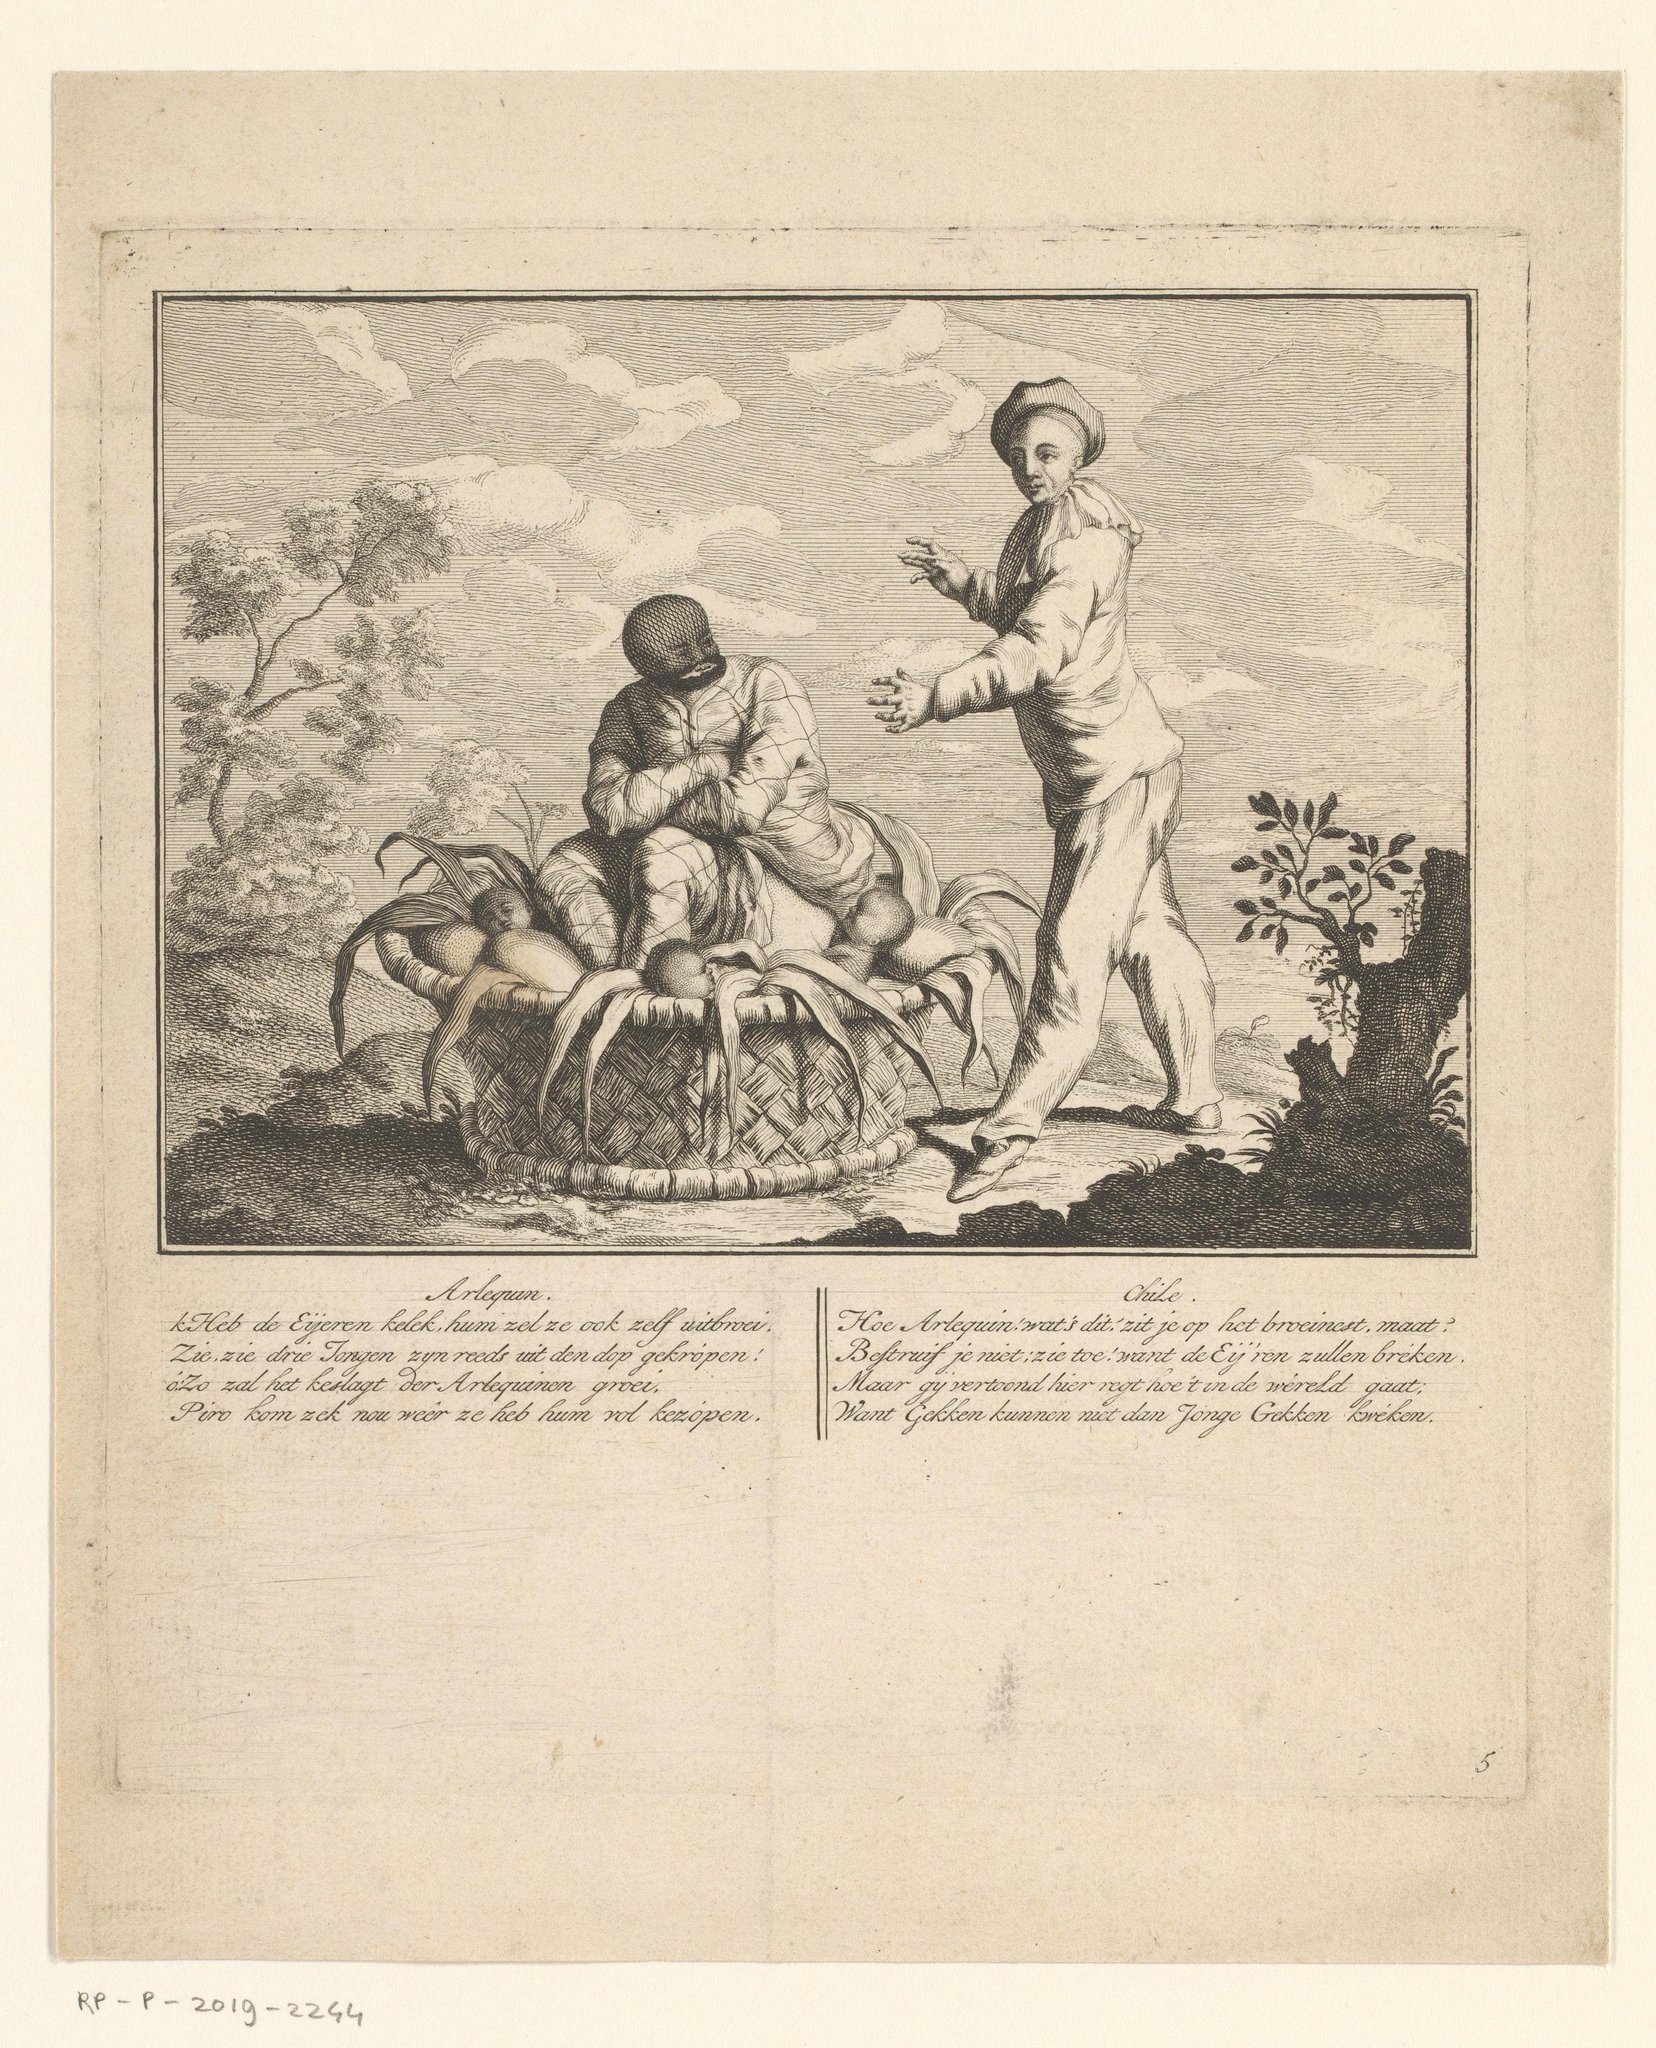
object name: print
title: Arlequin als opvoeder van de kleine Arlequin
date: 1720-1728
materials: paper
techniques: engraving, etching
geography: amsterdam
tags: types in 'commedia dell'arte', brooding, types in 'commedia dell'arte': harlequin, 'commedia dell'arte'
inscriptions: collector's mark: Lugt 2228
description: Maakt deel uit van een zestiendelige serie met scènes uit het Italiaanse toneel.